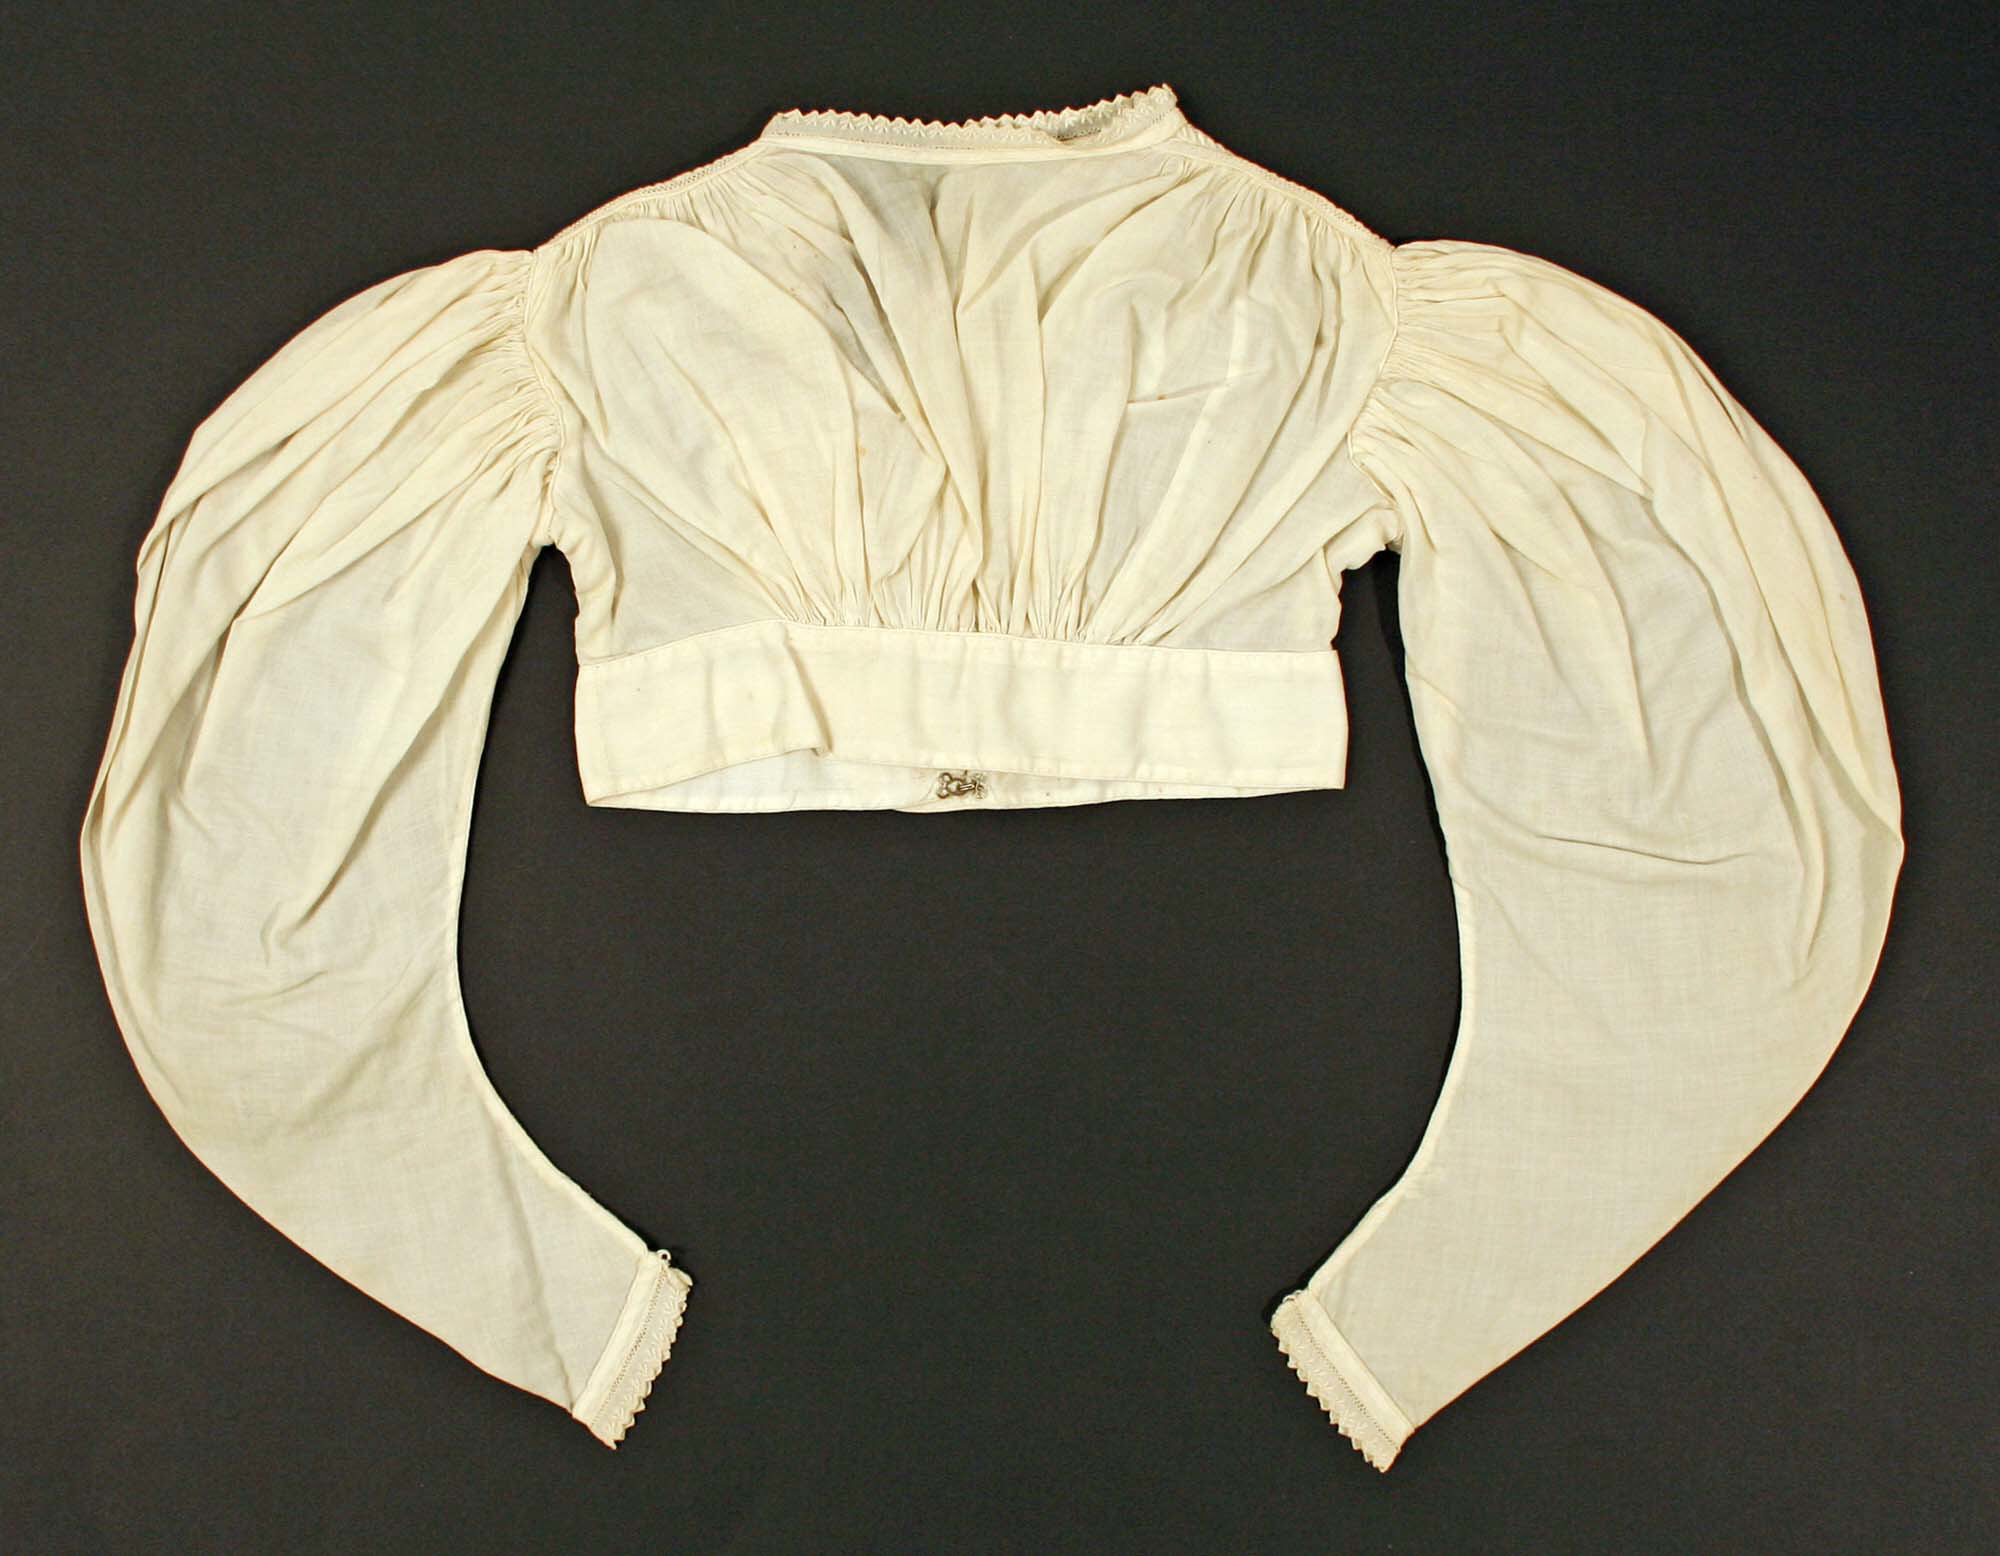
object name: chemise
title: Chemisette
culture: american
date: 1835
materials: cotton